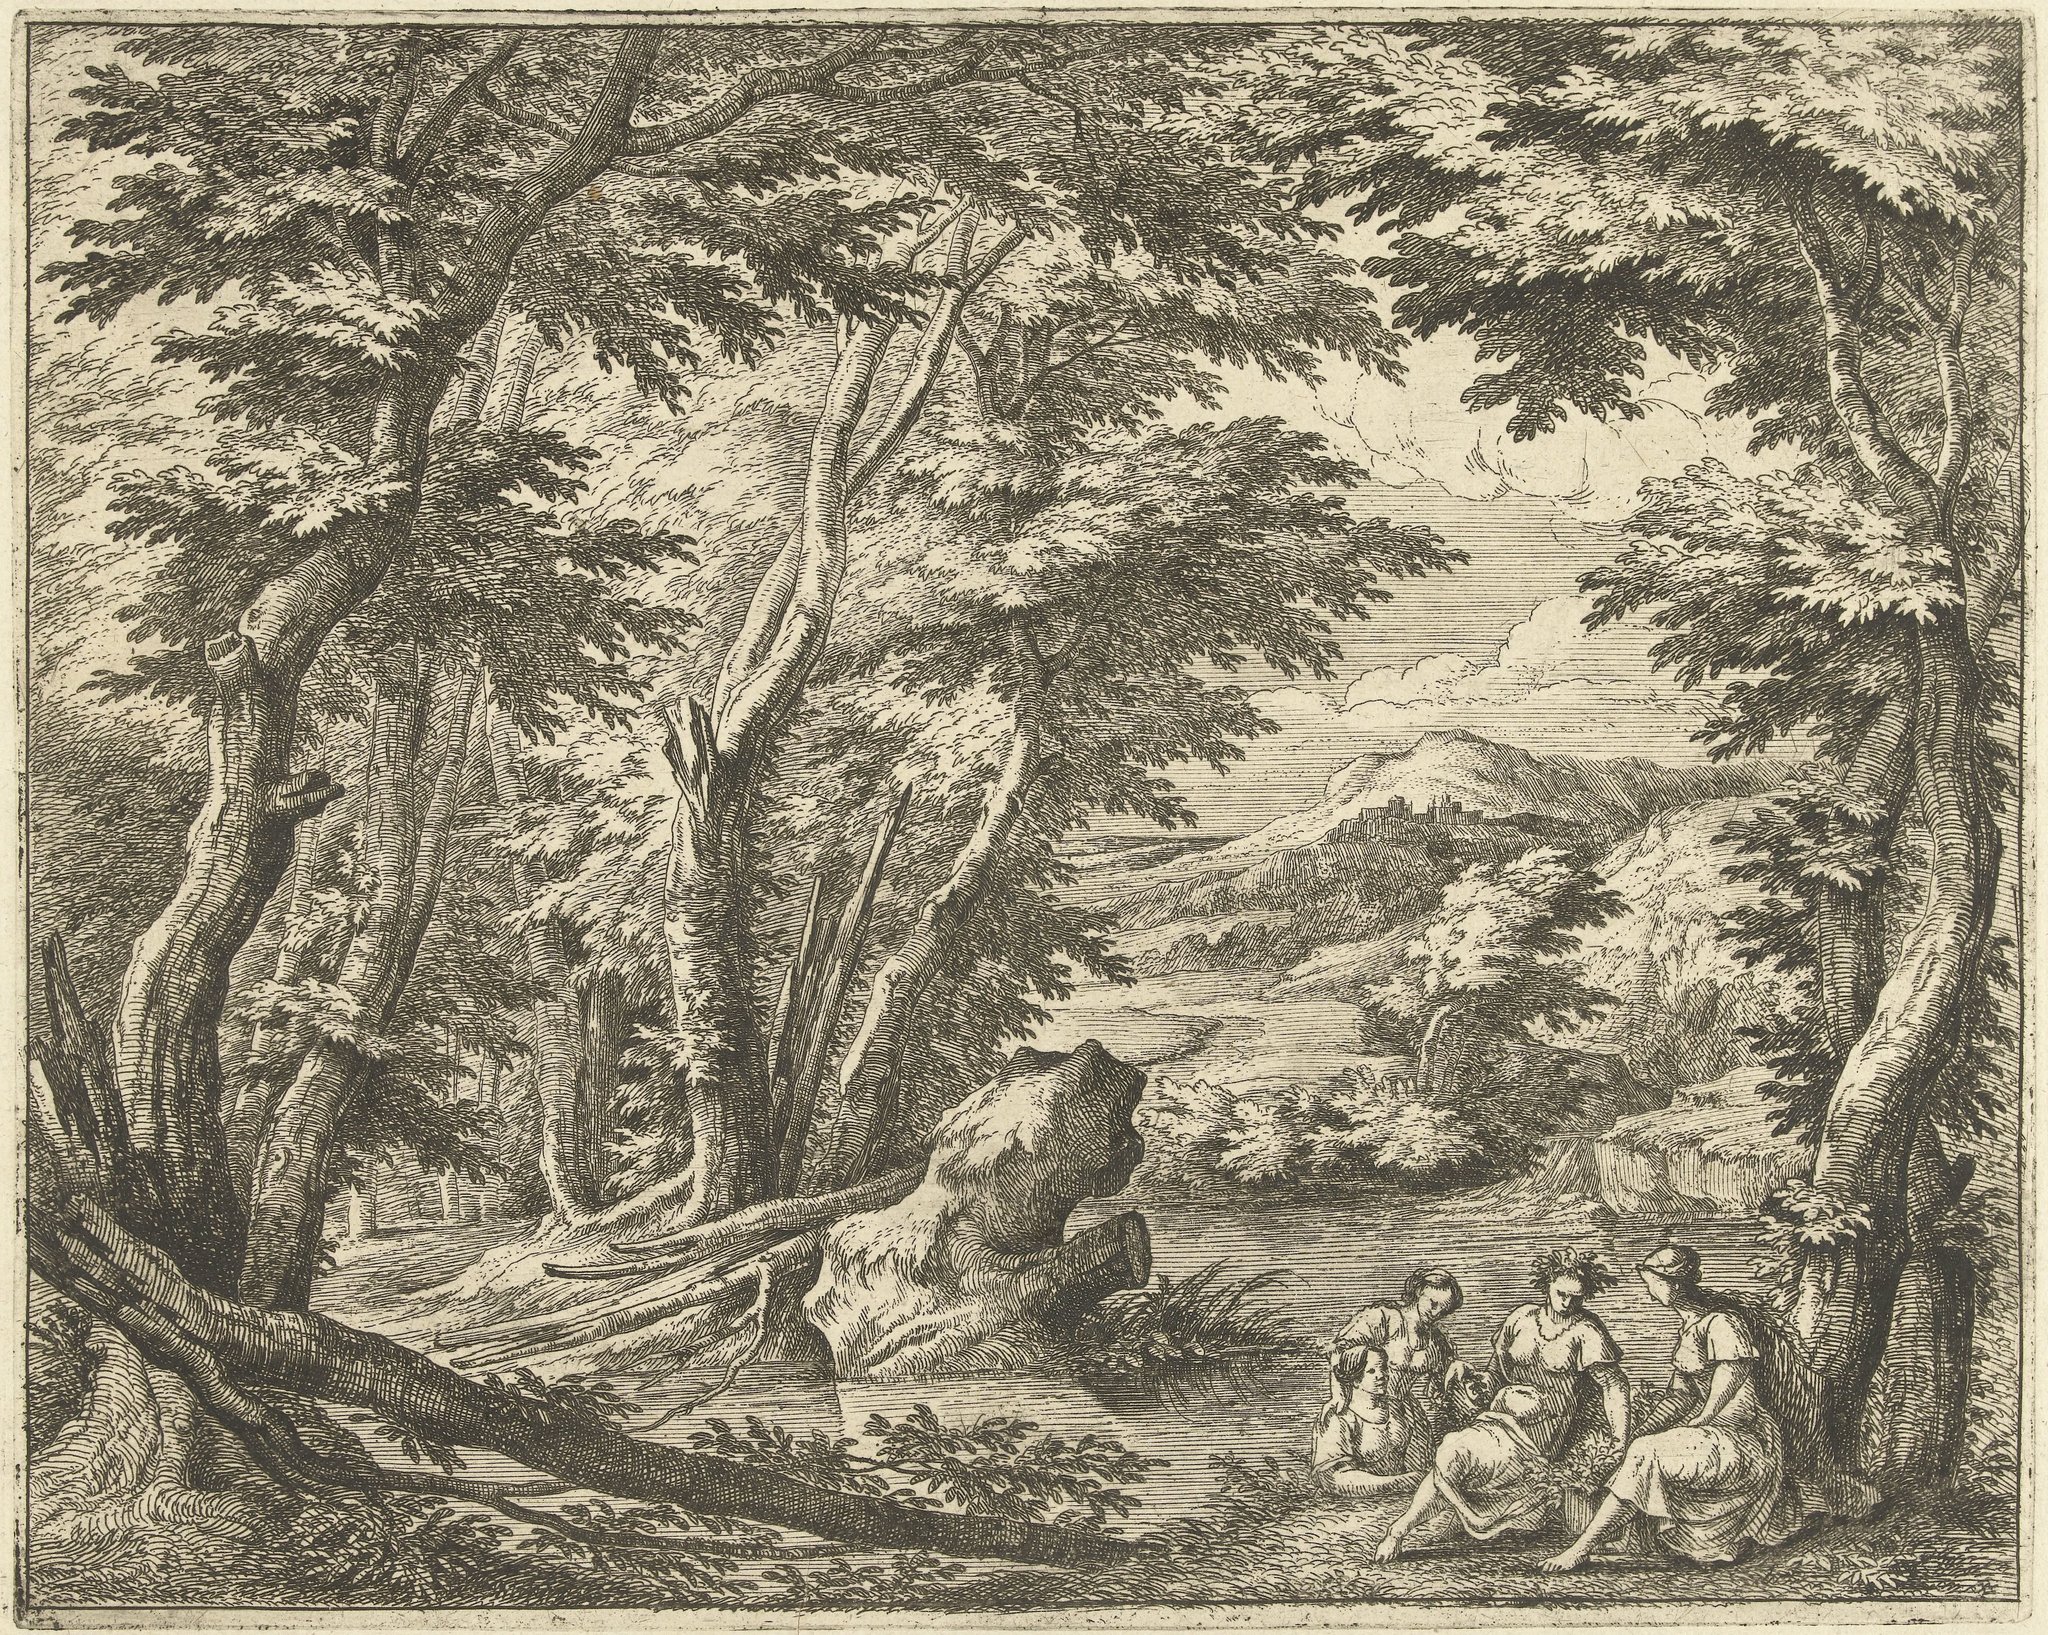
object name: print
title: Landschap met vier jonge vrouwen aan de oever van een rivier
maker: adriaen frans boudewyns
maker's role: draughtsman, print maker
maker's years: 1644-1711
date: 1660-1700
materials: paper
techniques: etching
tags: glade, 'lichtung im wald' (+ landscape with figures, staffage)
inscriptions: collector's mark: Lugt 240